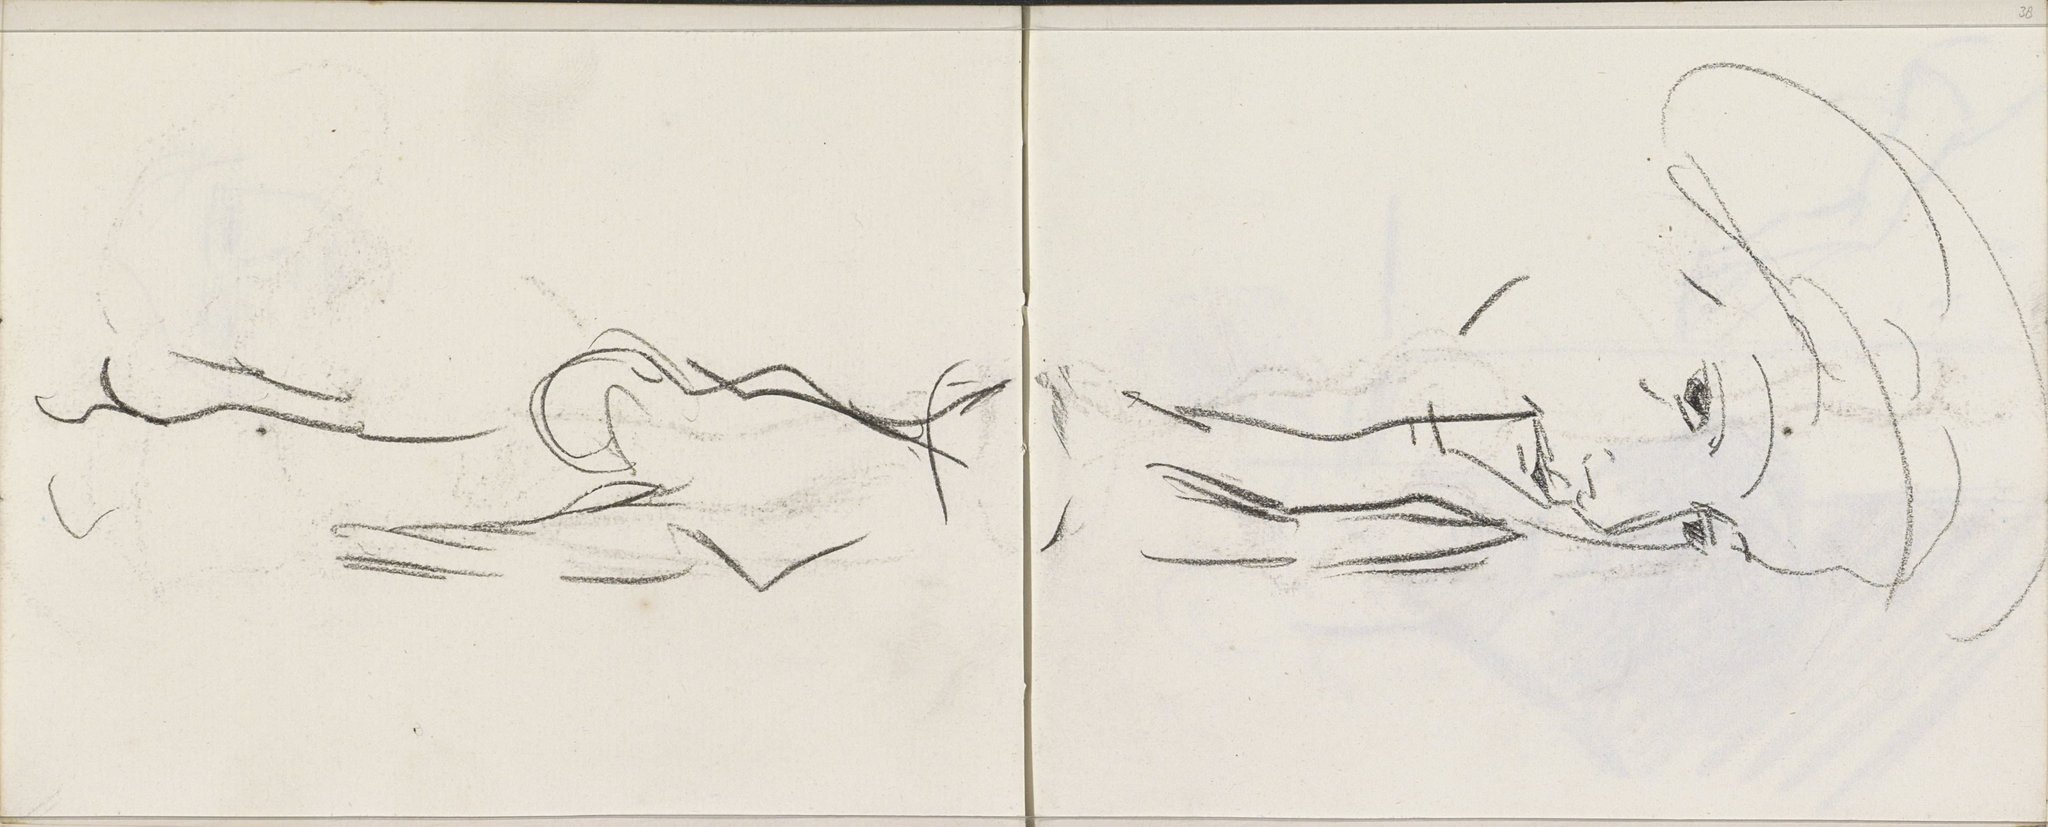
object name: sketchbook leaf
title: Figuurstudies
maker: isaac israels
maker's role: draughtsman, painter, print maker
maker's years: 1865-1934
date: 1875-1934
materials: chalk, paper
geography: the hague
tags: the (nude) human figure; 'corpo humano' (ripa) (+ lying), head (human) - aa - female human figure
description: Vrouwenhoofd en mogelijk een liggende figuur. Pagina 37 en pagina 38 uit schetsboek XLIII met 61 pagina's.